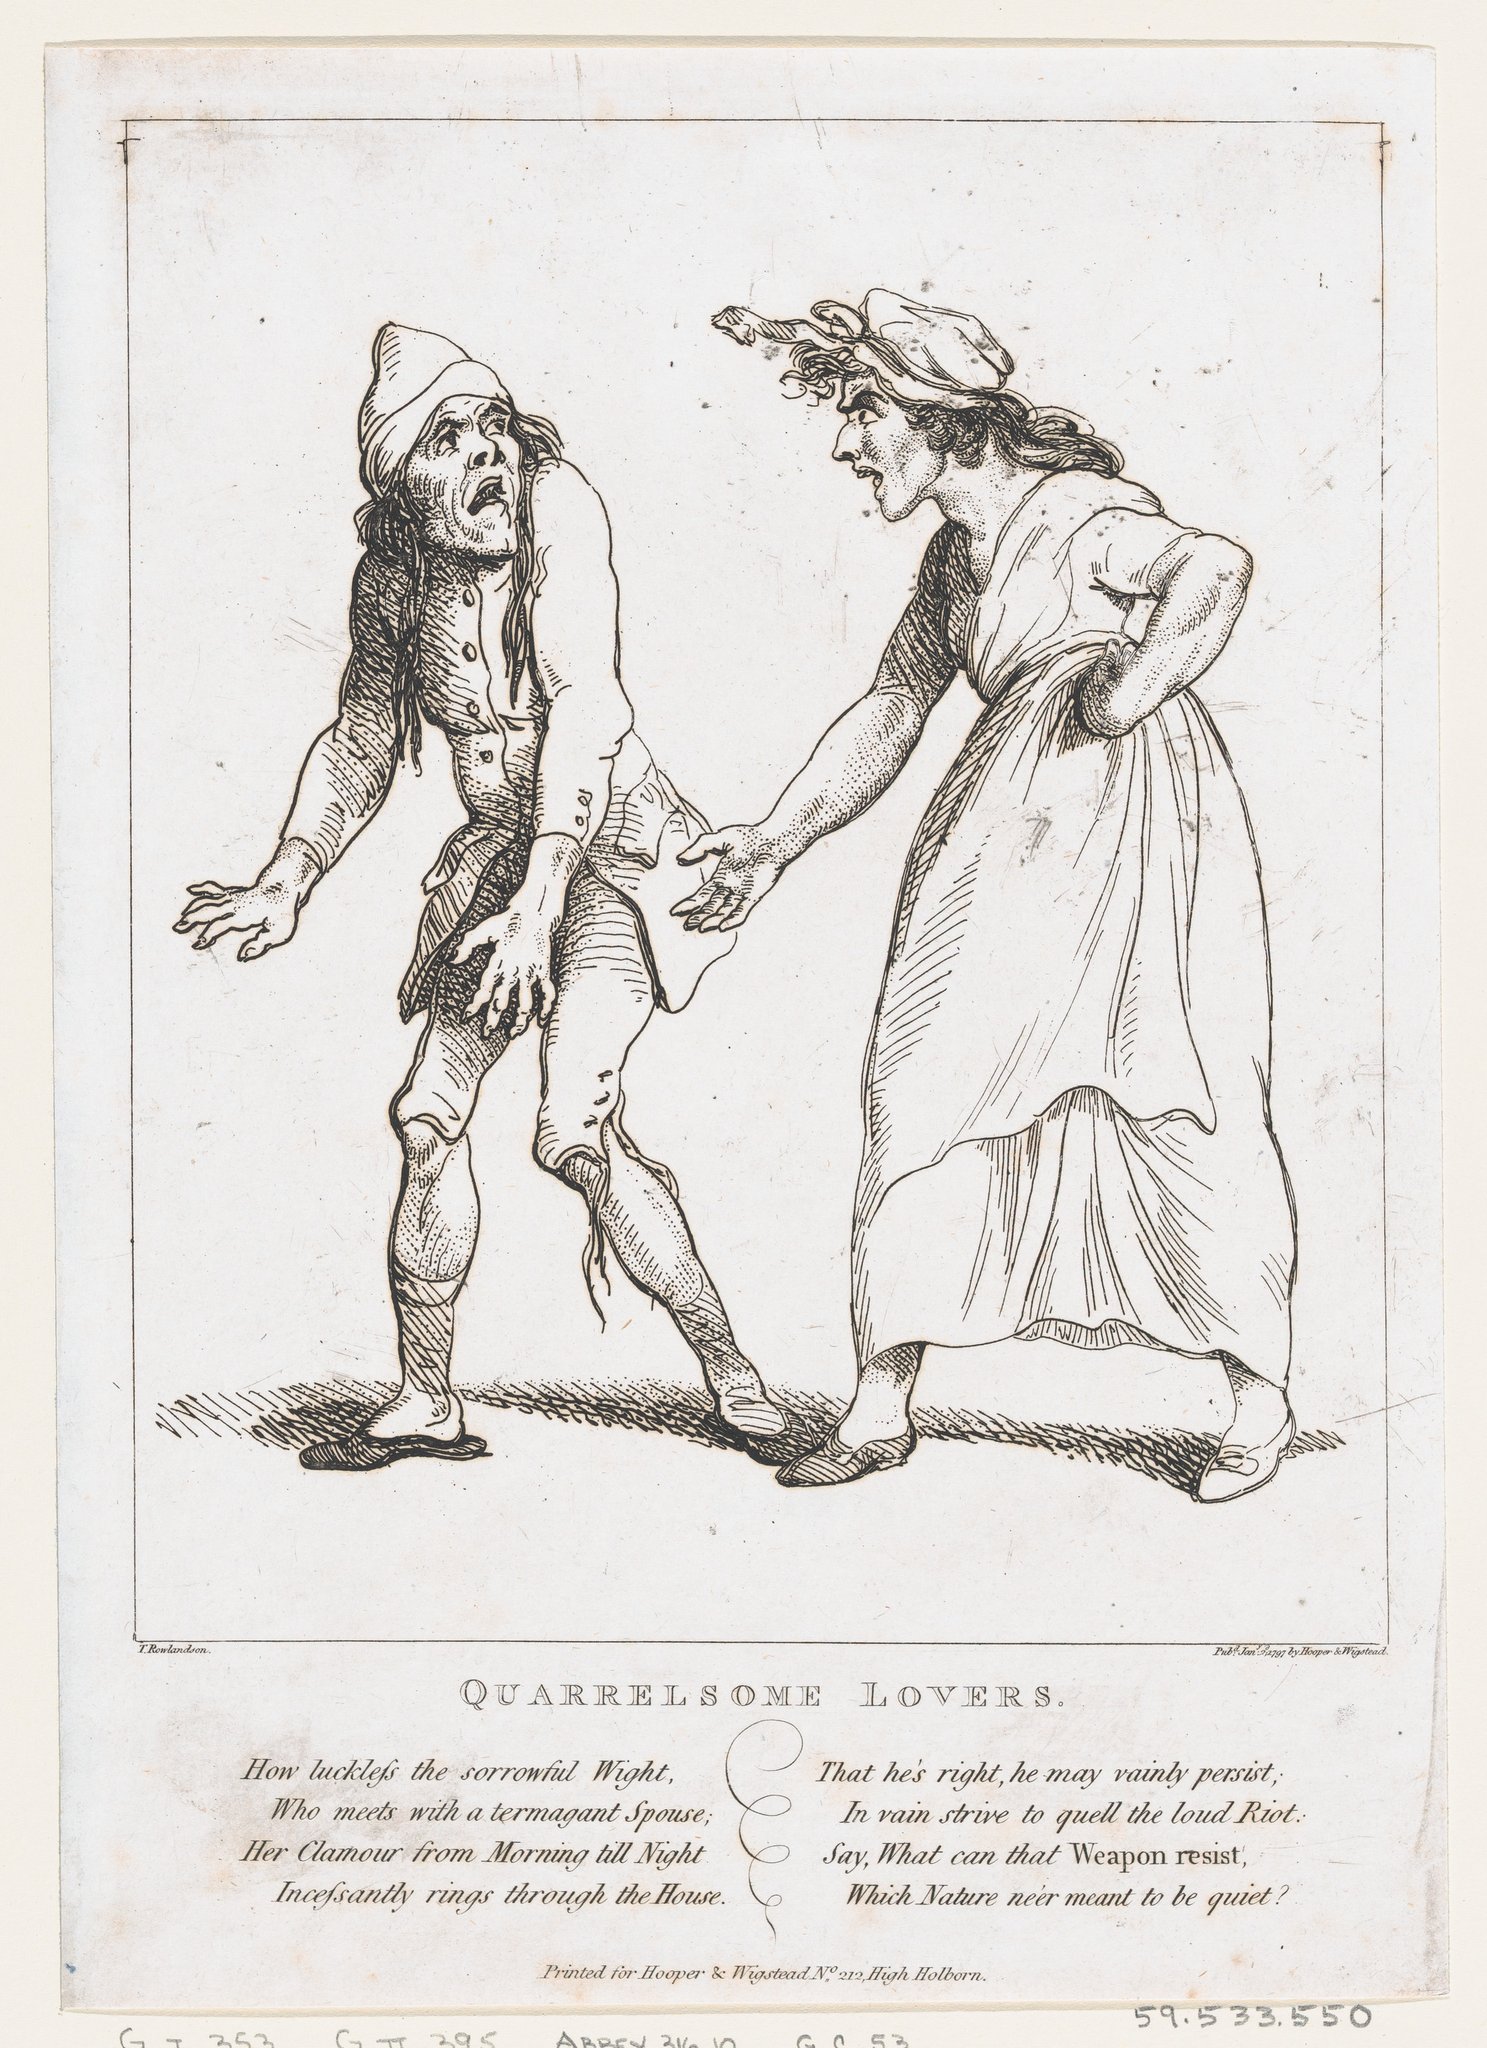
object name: print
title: Quarrelsome Lovers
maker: thomas rowlandson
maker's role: artist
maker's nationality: british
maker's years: 1757-1827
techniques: etching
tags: men,lovers,women